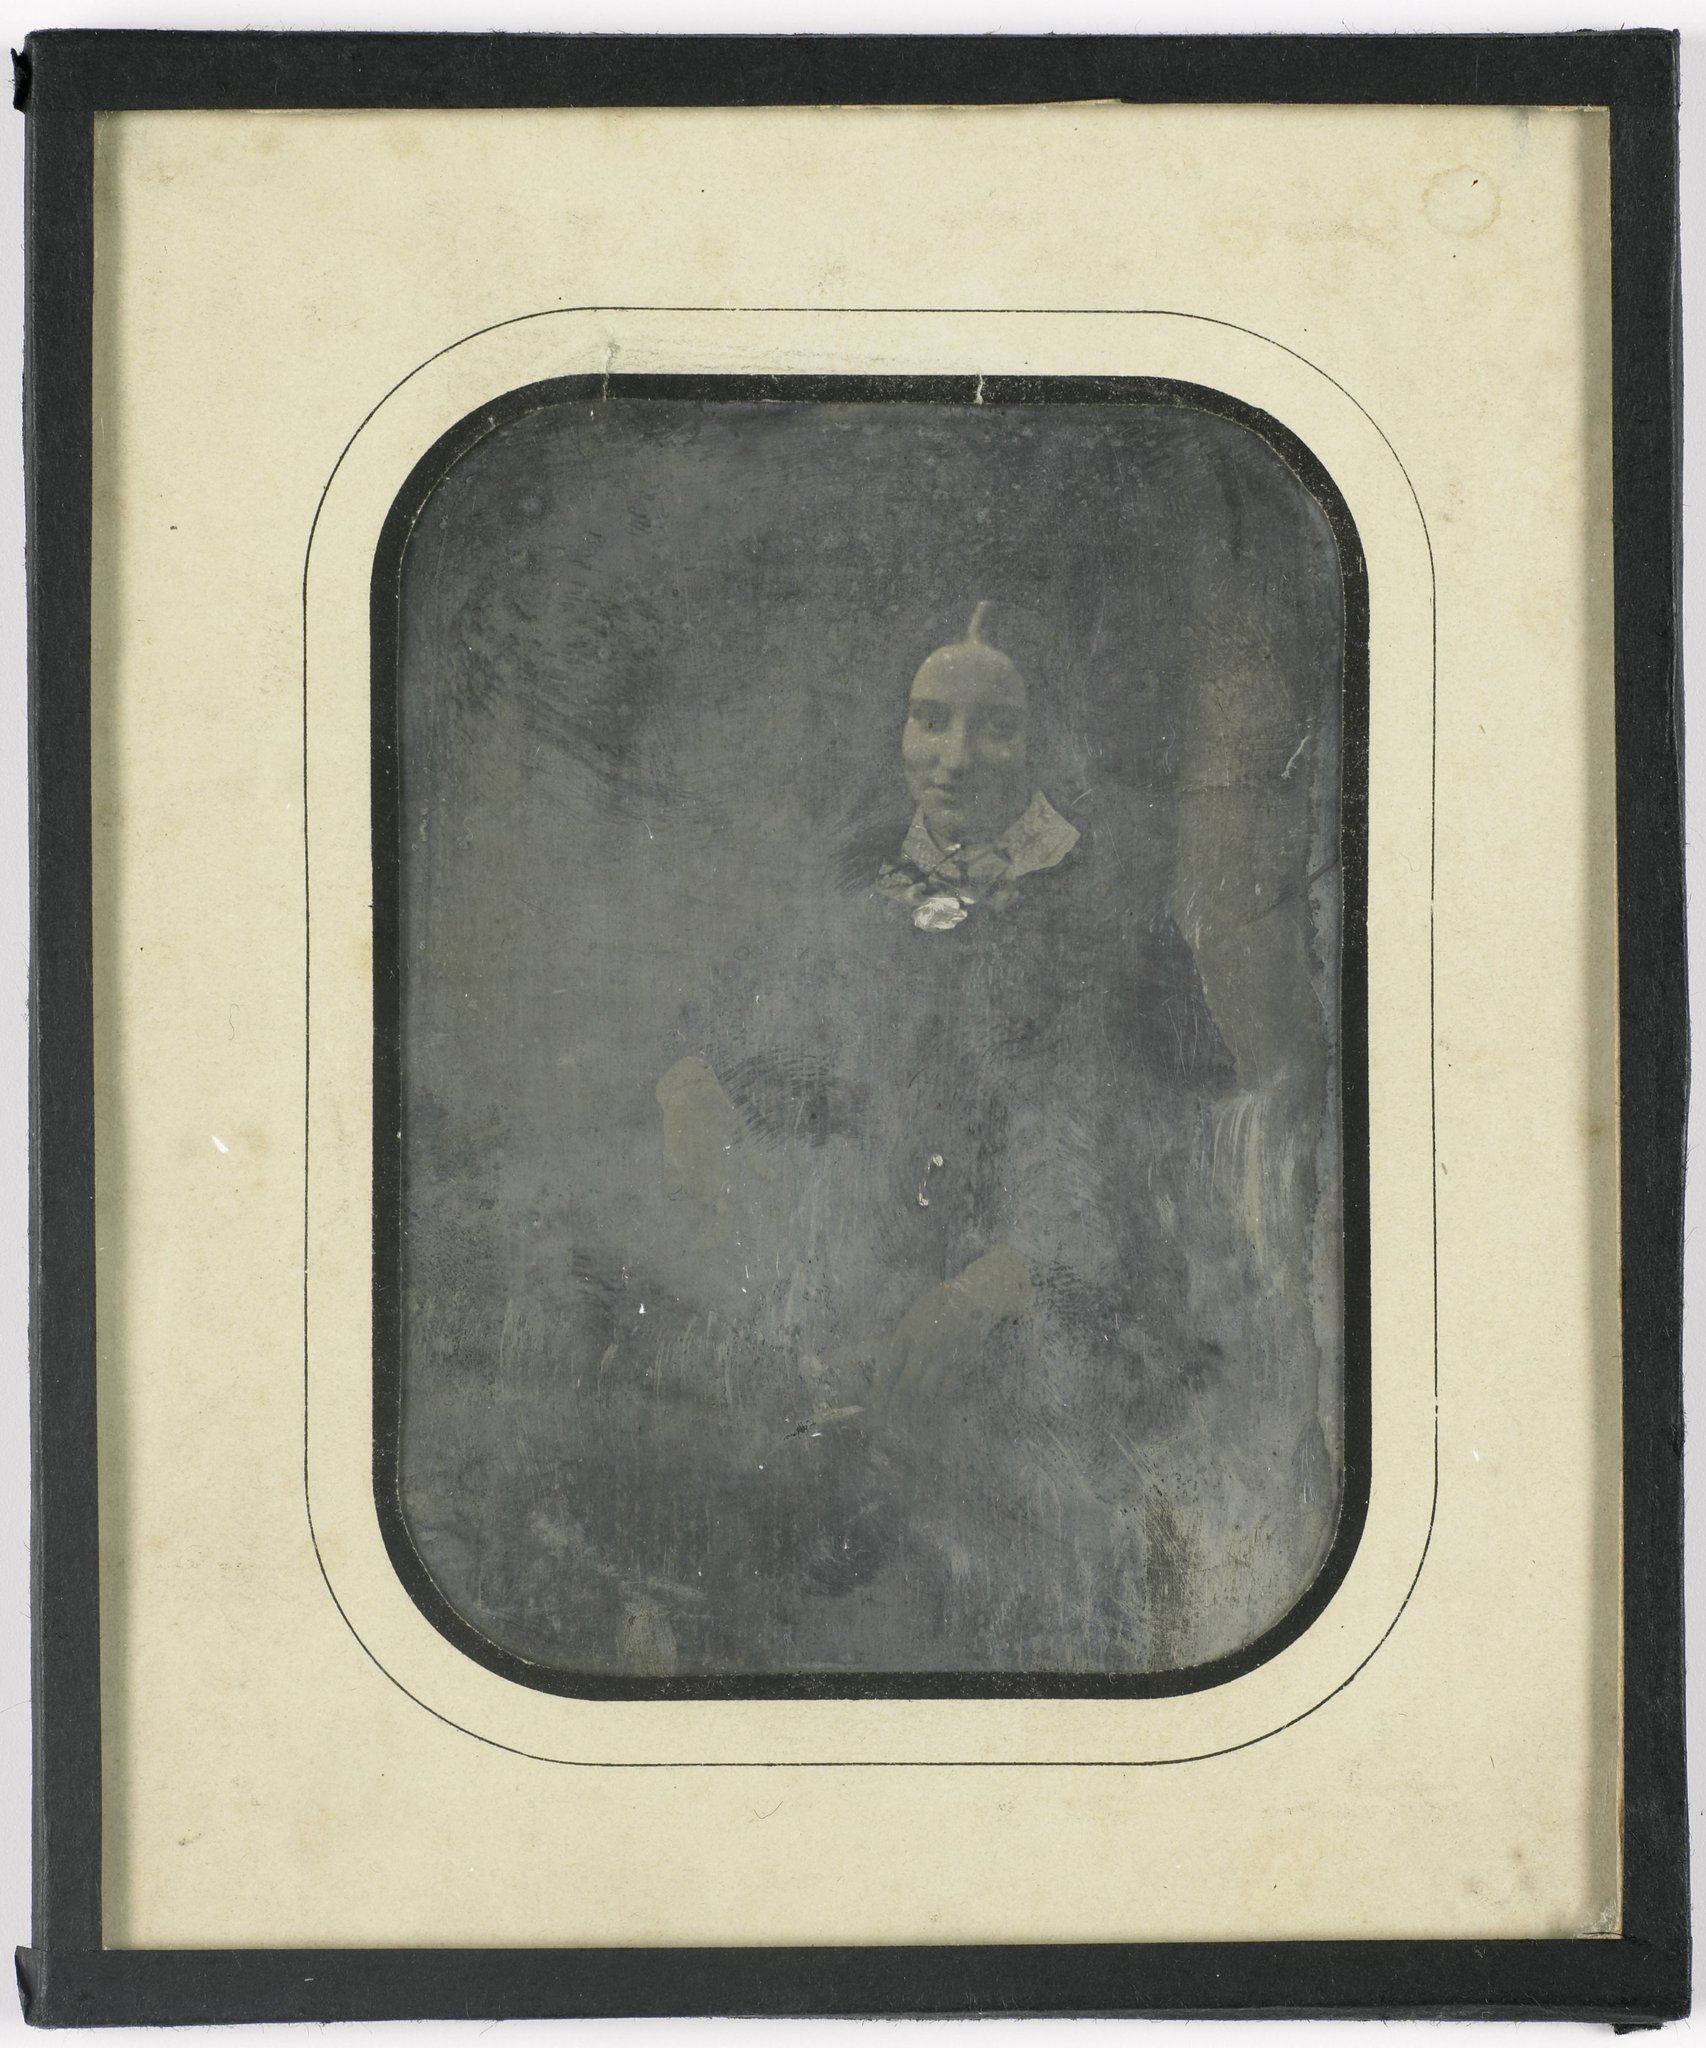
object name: photograph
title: Portret van een onbekende vrouw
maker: jean simon guyard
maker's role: painter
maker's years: 1792-1851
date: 1844-1851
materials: copper, glass, paper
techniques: daguerreotype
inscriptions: inscription: ‘Estab. de Mr& Mme Guyard, situé Prinsegracht bij de Vijzelstraat 96,79 (...)’